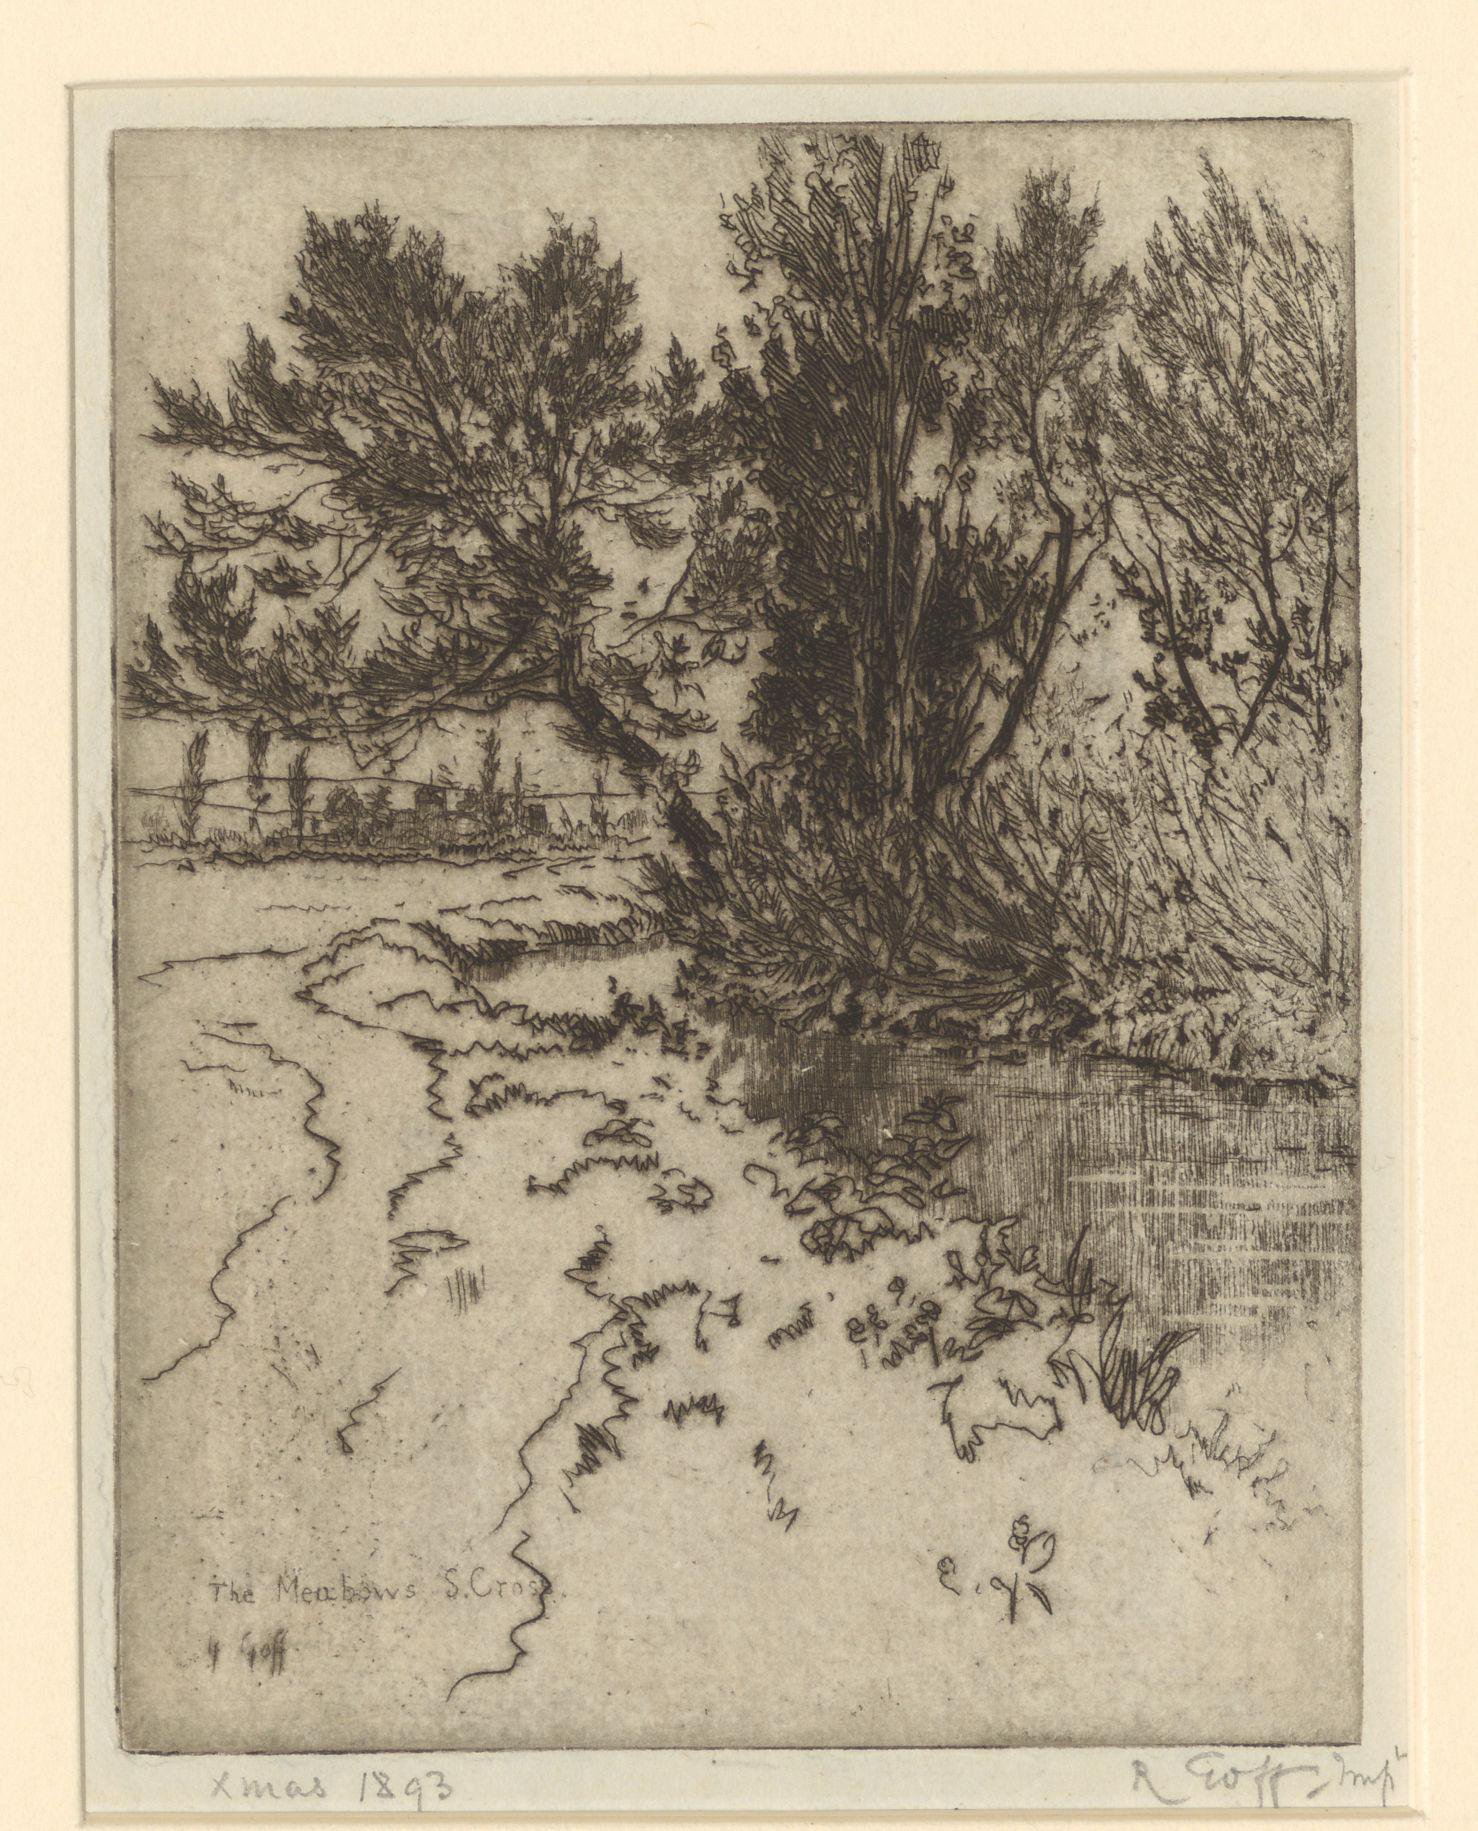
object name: print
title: Bomen bij een beek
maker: robert charles goff (1837-1922)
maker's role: painter, print maker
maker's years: 1837-1922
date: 1878-1922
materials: paper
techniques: drypoint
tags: brook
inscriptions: collector's mark: Lugt 2760, collector's mark: Lugt 2228